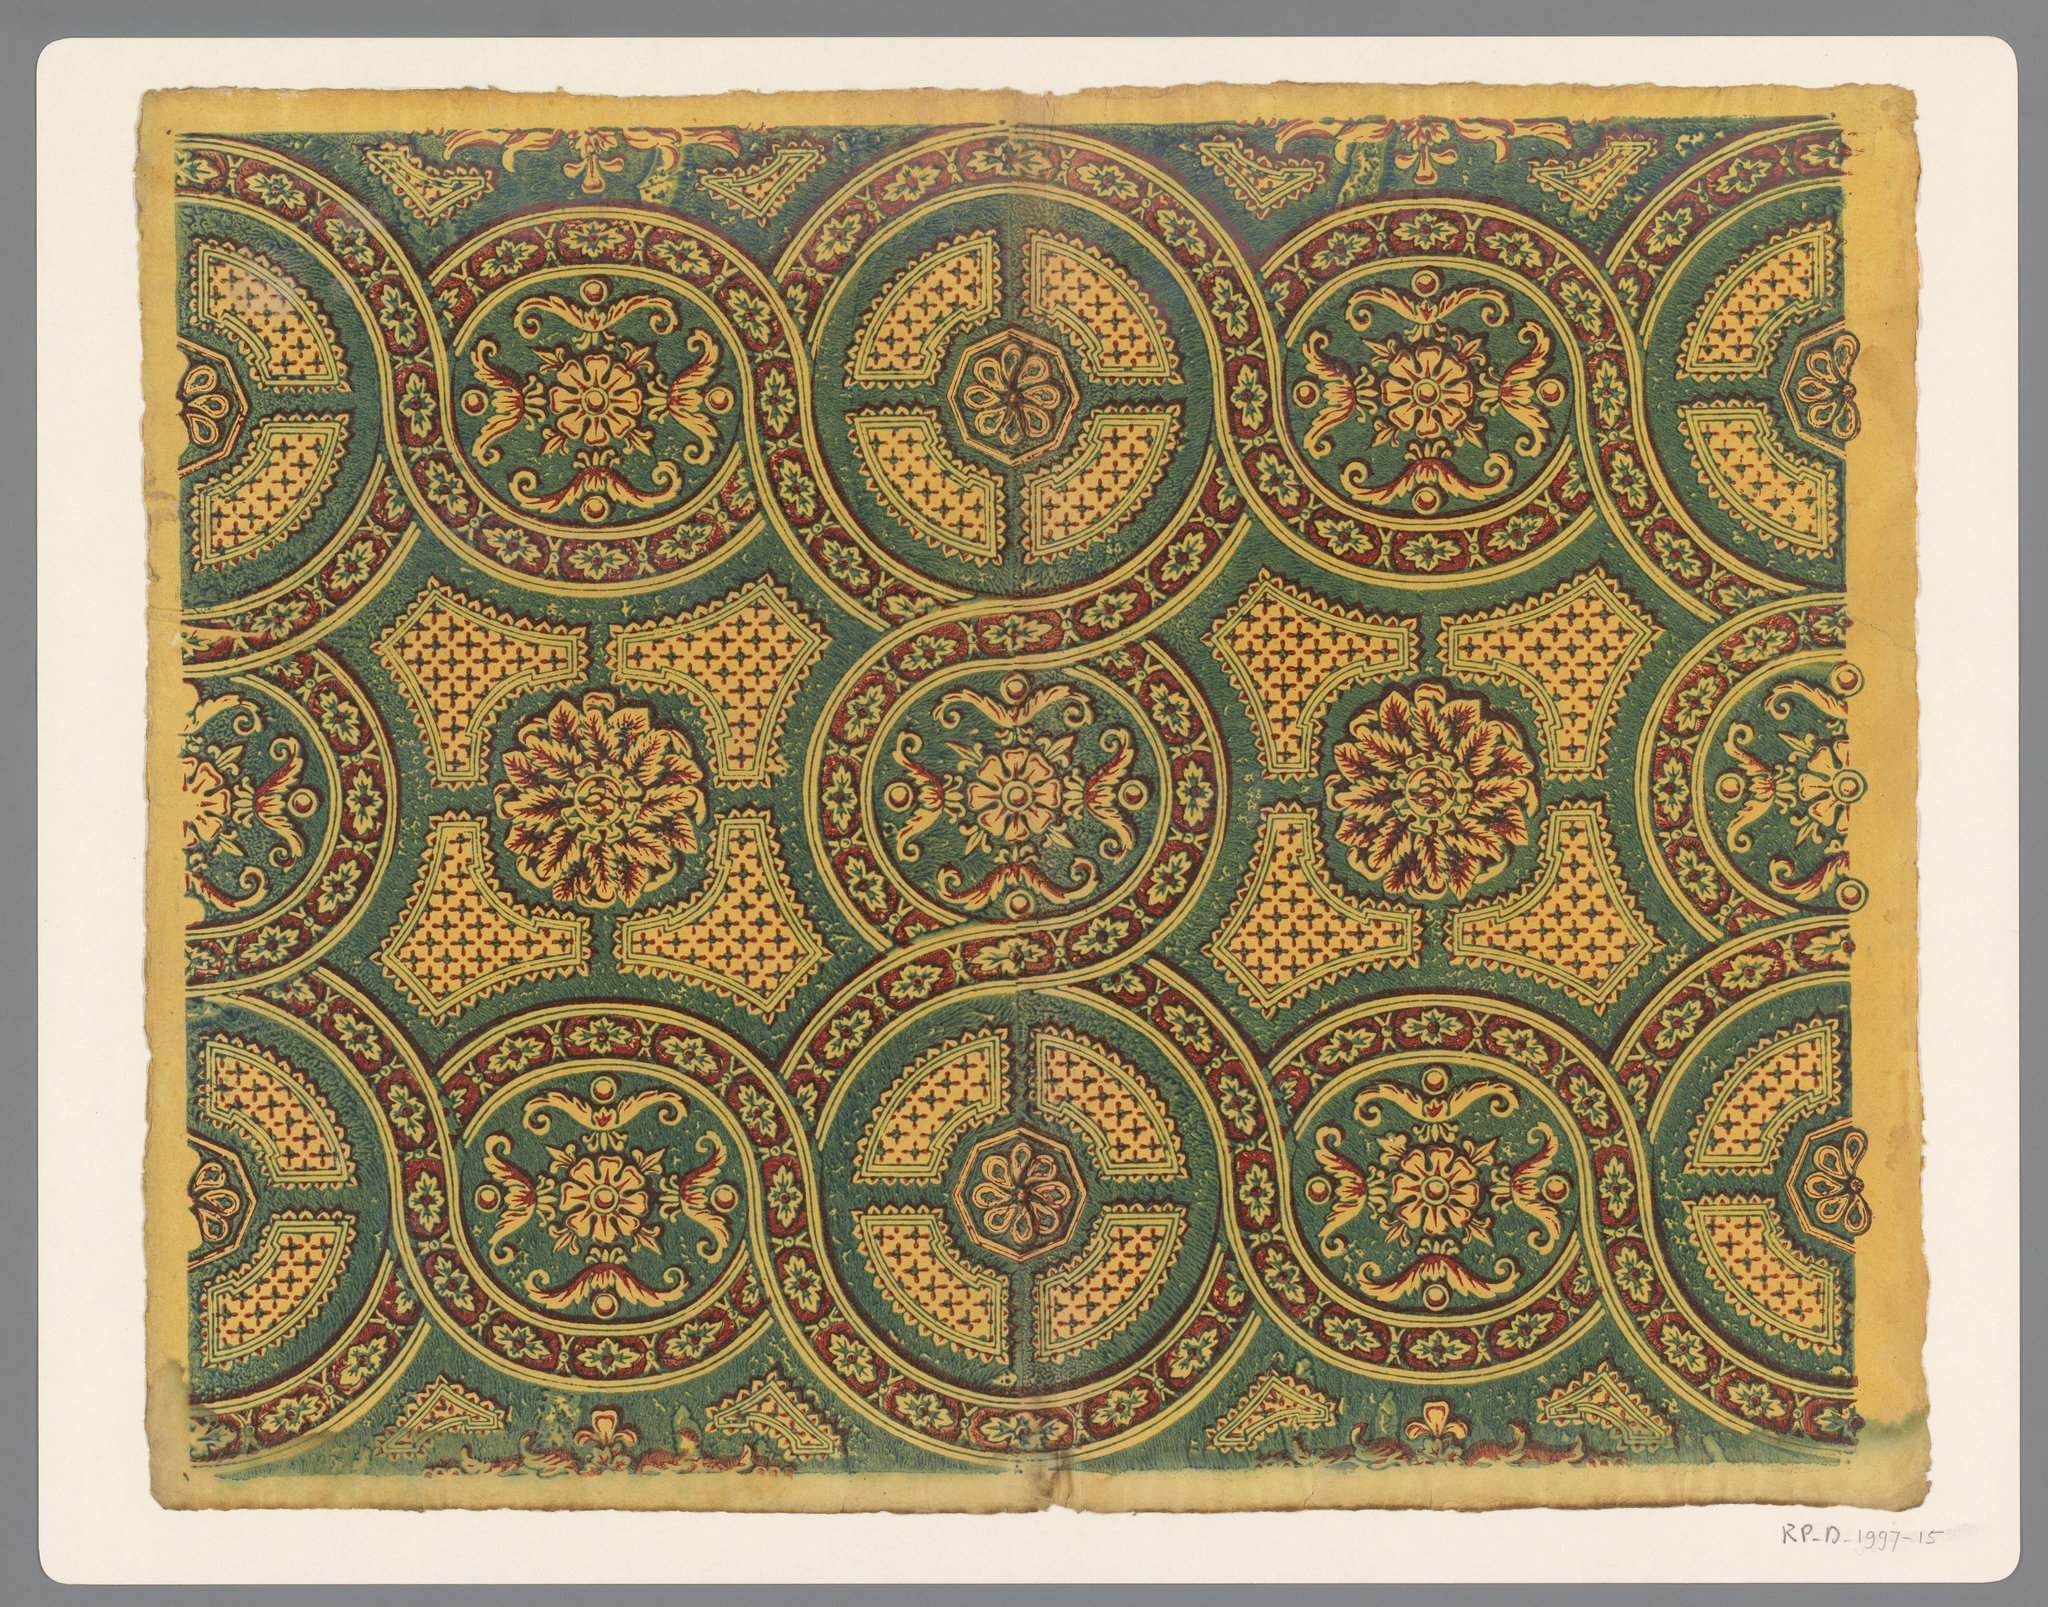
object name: printed paper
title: Blad met florale ornamenten in vlechtwerk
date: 1700-1860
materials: paper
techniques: printing block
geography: bassano del grappa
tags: ornament derived from plant forms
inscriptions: collector's mark: Lugt 2760, collector's mark: Lugt 2228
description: Blad met florale ornamenten in vlechtwerk, vergelijkenis vertonend met stucwerk plafond.